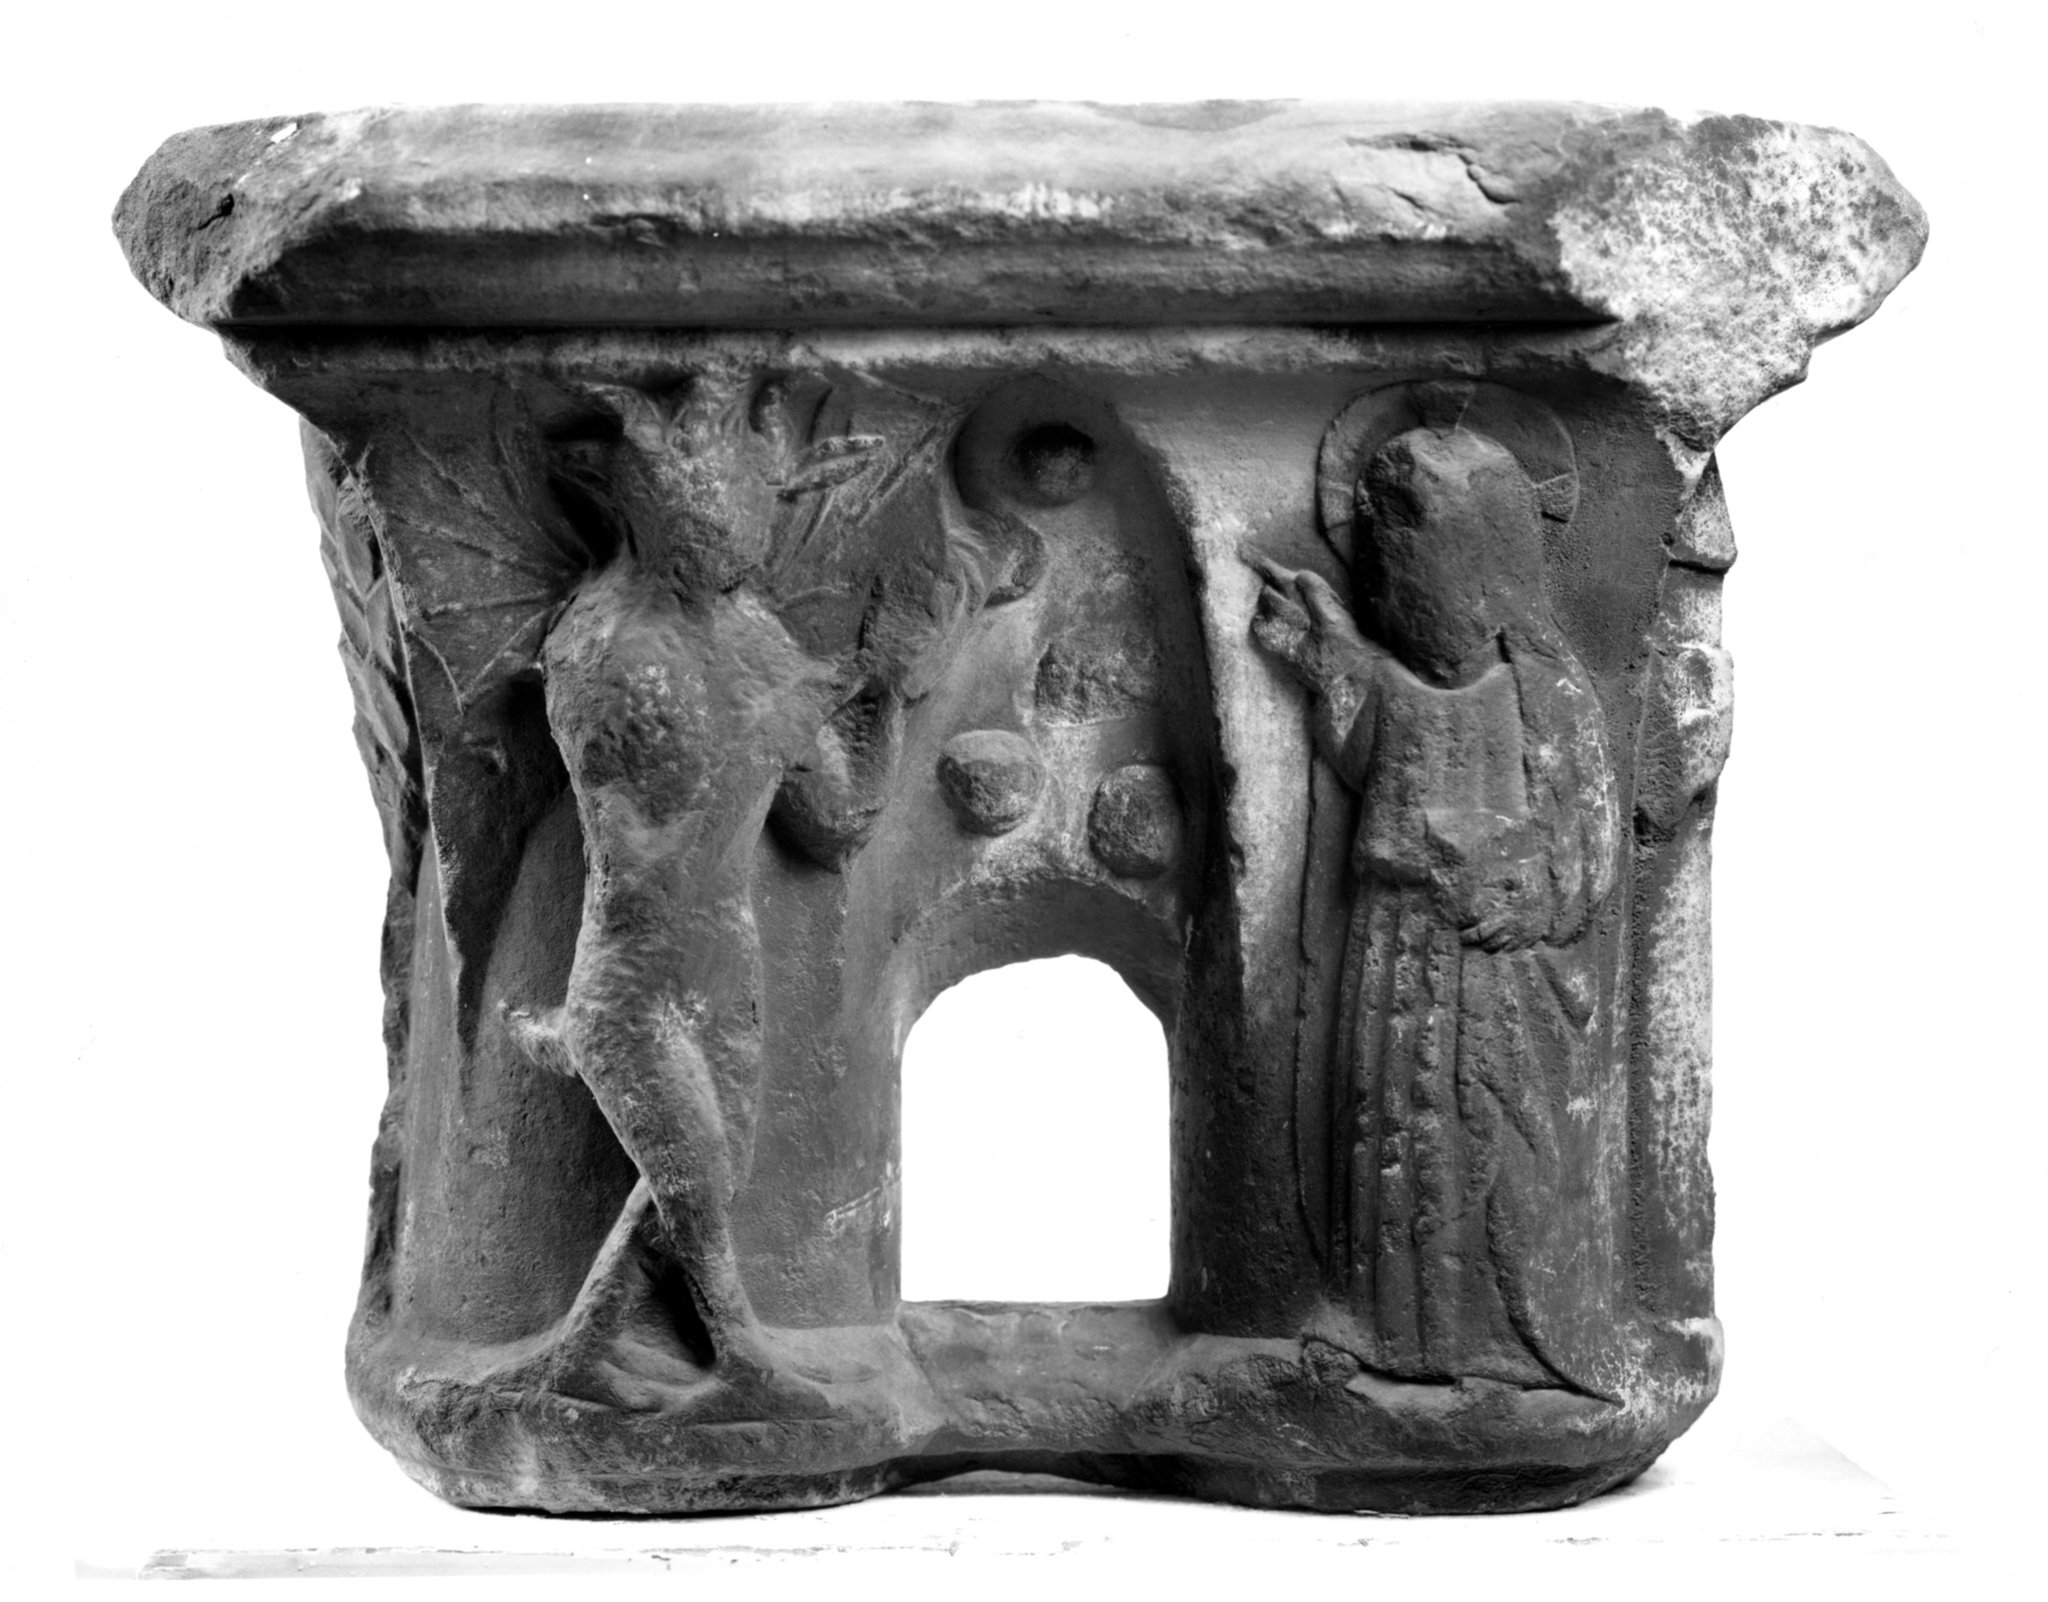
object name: capital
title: Double Capital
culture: french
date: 1467-1500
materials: marble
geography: france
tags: christ,devil